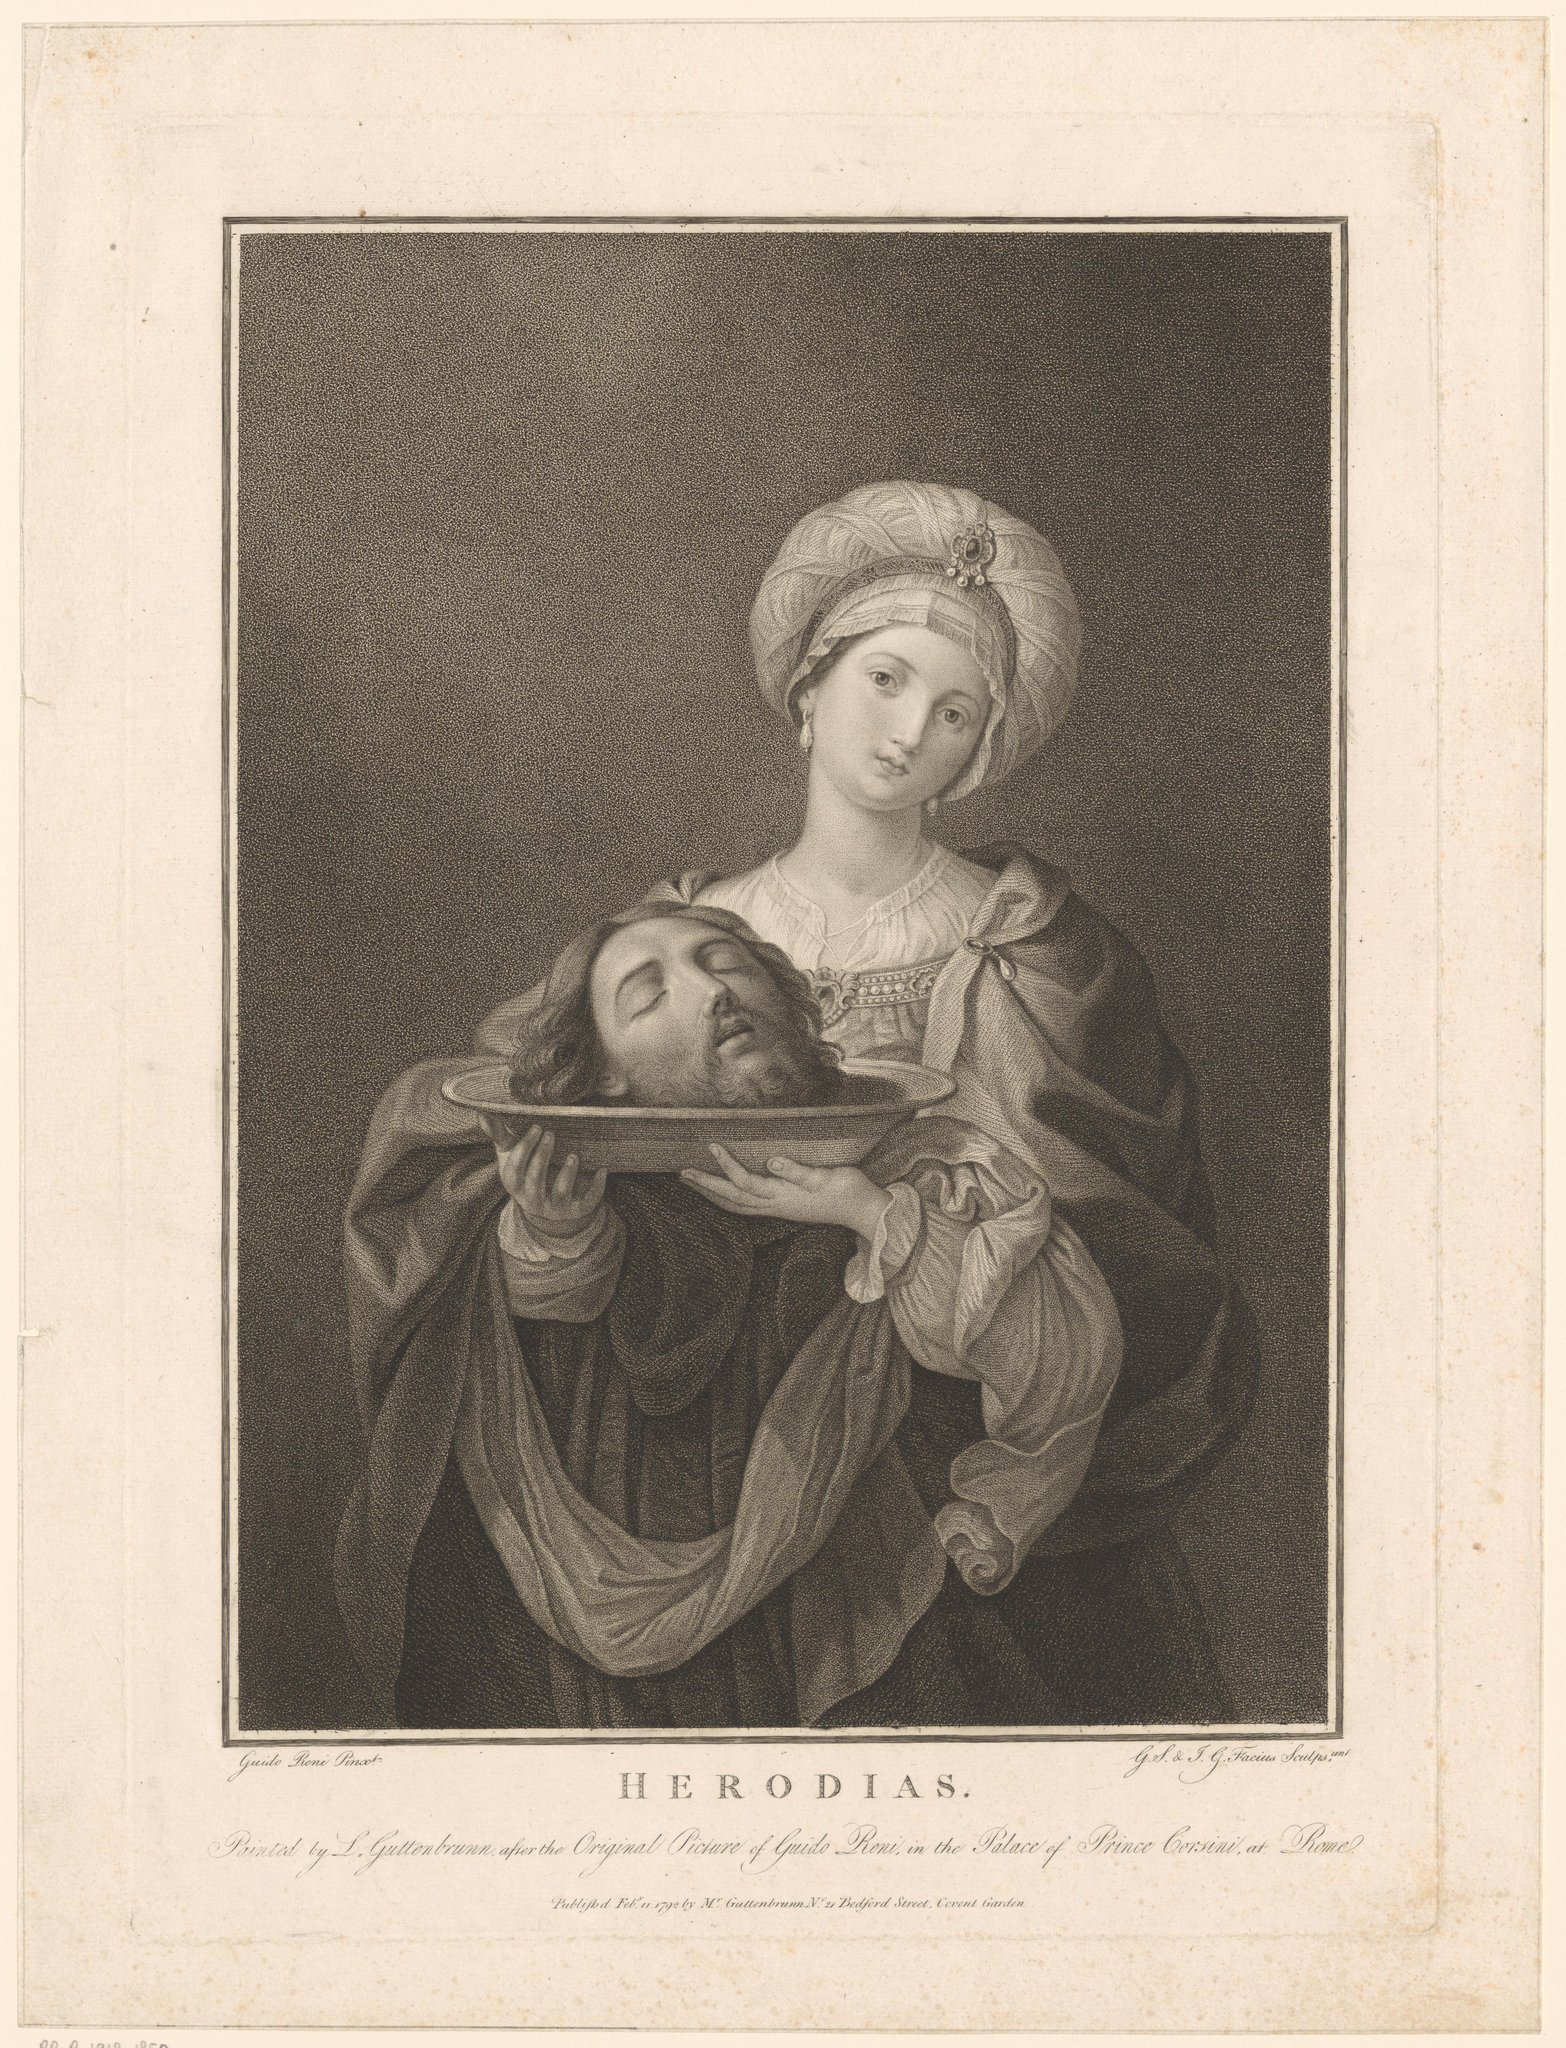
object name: print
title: Salome met het hoofd van Johannes de Doper op een schaal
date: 1702-1792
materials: paper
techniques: stippling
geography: london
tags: salome with the head of john the baptist on a dish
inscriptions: collector's mark: Lugt 2233